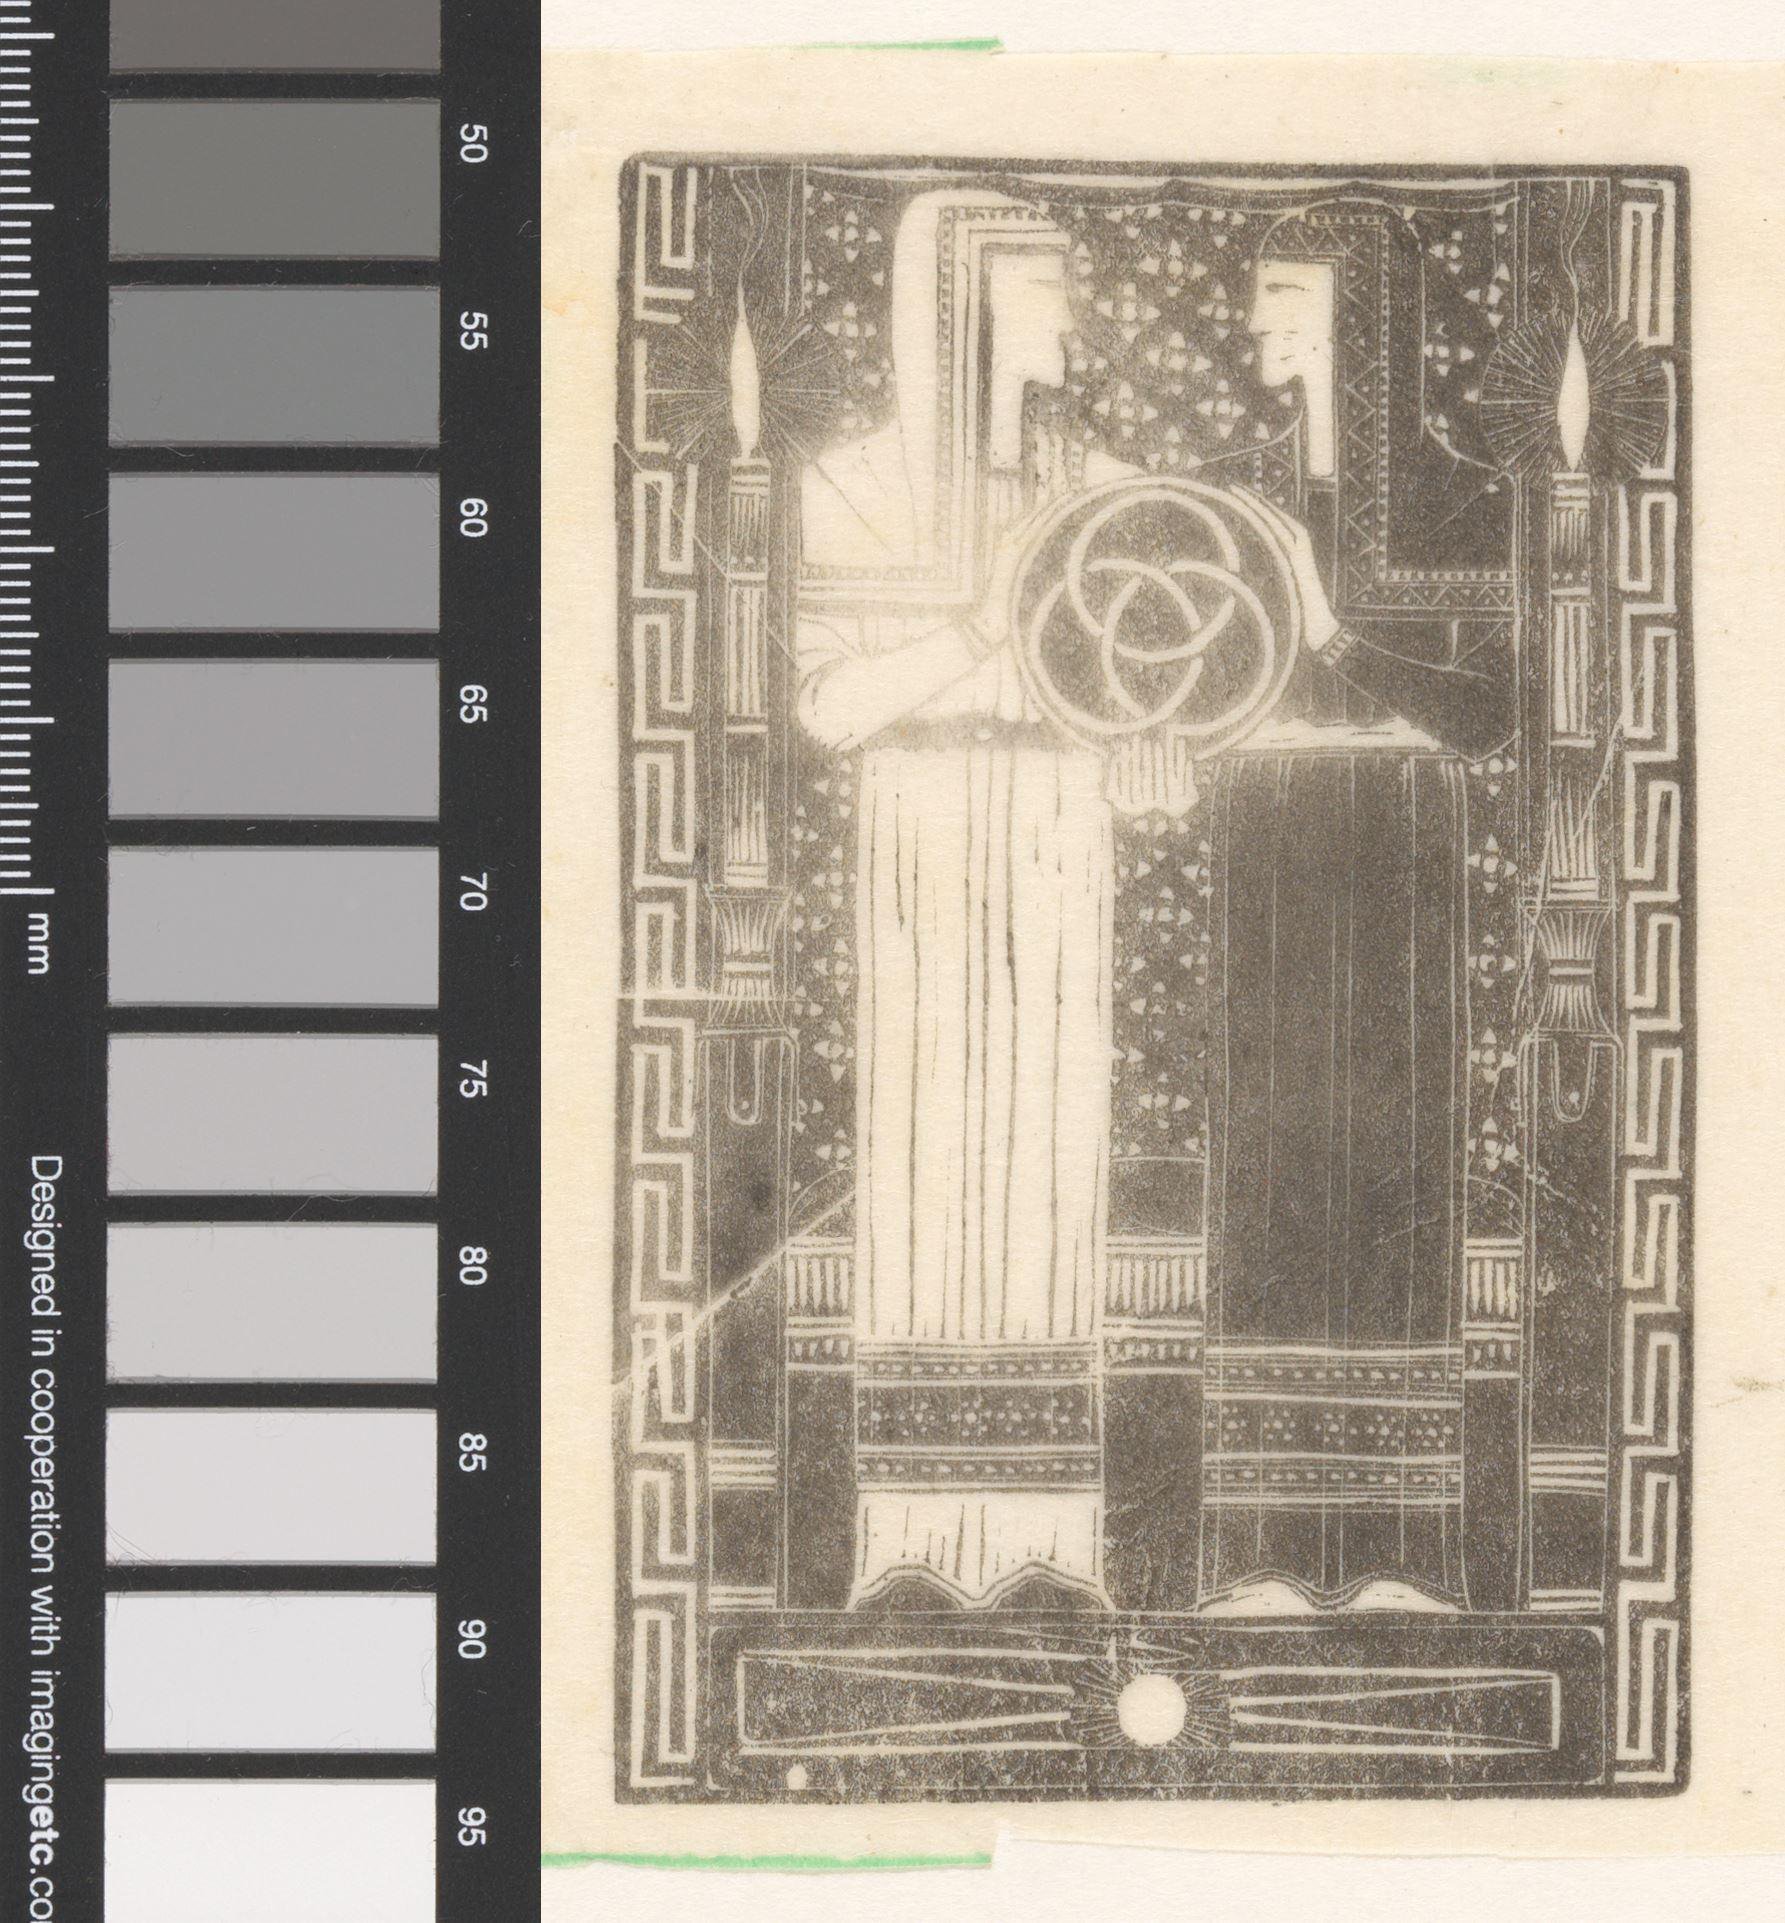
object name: illustration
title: Twee figuren met een cirkel met ringen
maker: mathieu lauweriks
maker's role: designer, draughtsman, print maker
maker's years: 1864-1932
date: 1895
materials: paper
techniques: woodcut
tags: three interlocked circles ~ trinity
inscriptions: collector's mark: Lugt 2228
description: Prent mogelijk gebruikt voor het gedicht 'De geest des tijds' in: Licht en waarheid. Orgaan van de vereeniging 'Wie Denkt Overwint'. Amsterdam: Wie Denkt Overwint, 8 juni 1895.